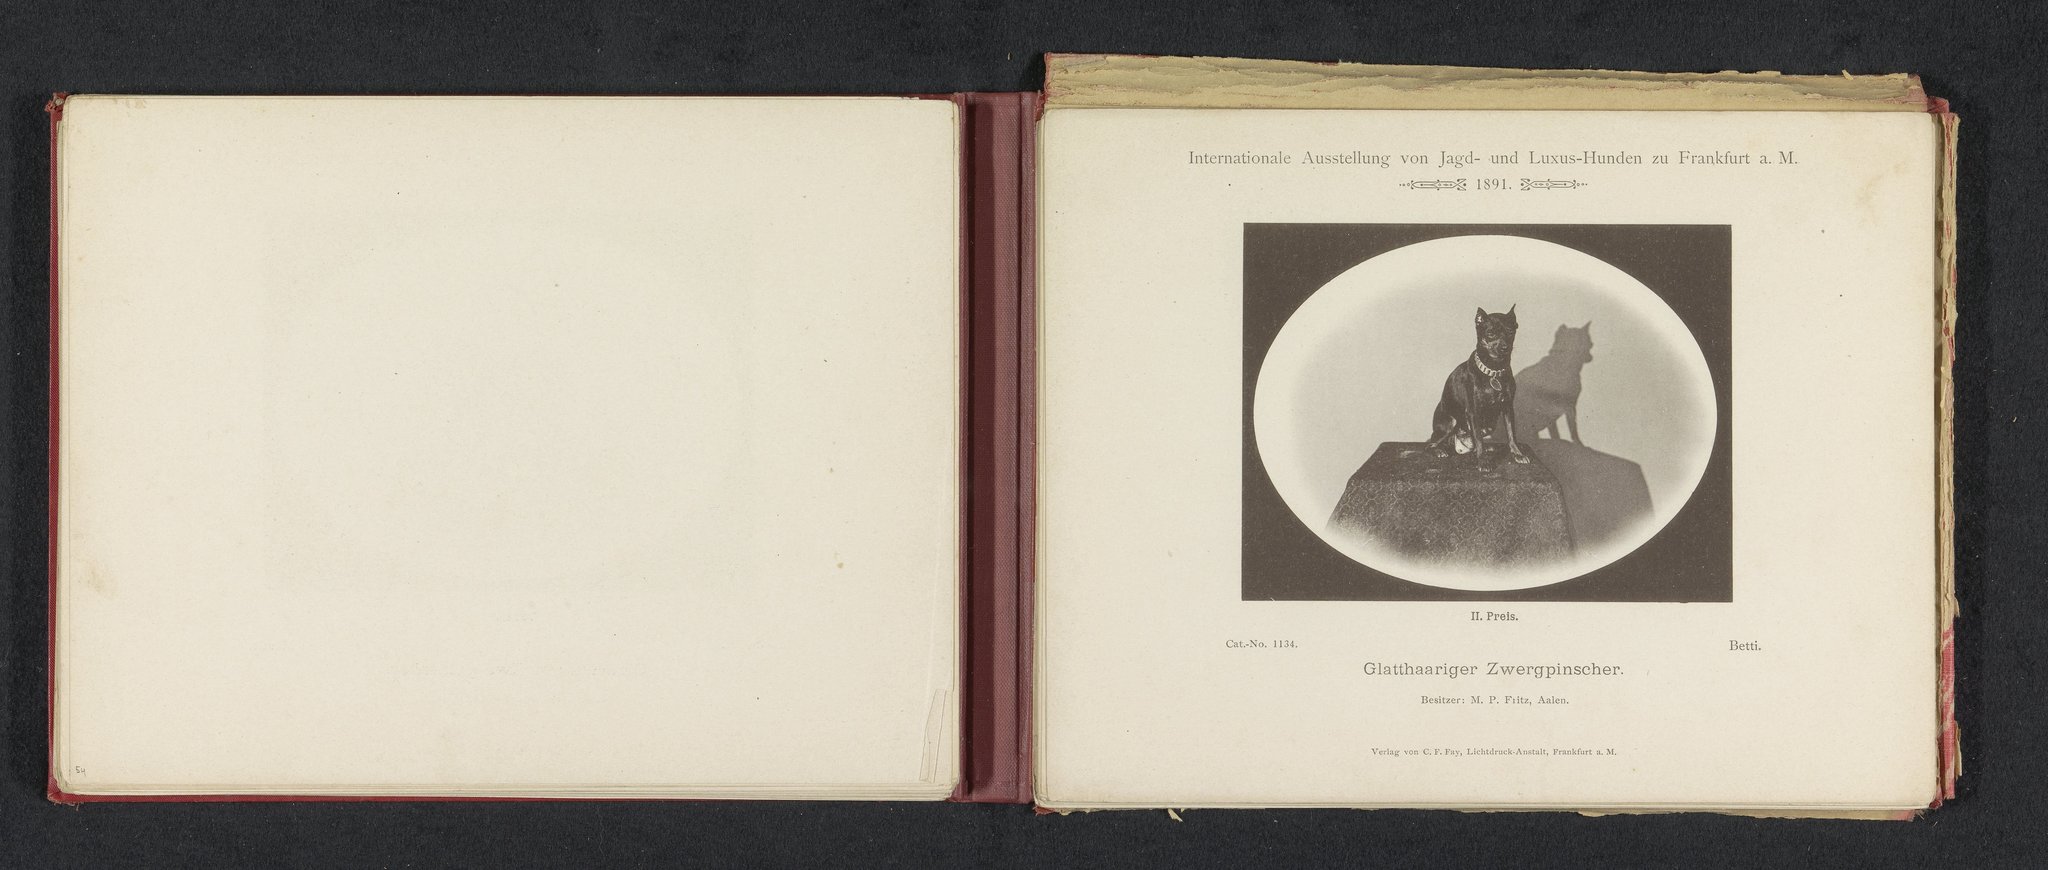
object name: page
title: Internationale Ausstellung von Jagd- und Luxus-Hunden zu Frankfurt a. M. 1891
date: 1891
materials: paper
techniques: photograph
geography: frankfurt am main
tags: dog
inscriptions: number: ‘Cat.-No. 1134.’, inscription: ‘II. Preis. Betti. Besitzer : M. P. Fritz, Aalen.’